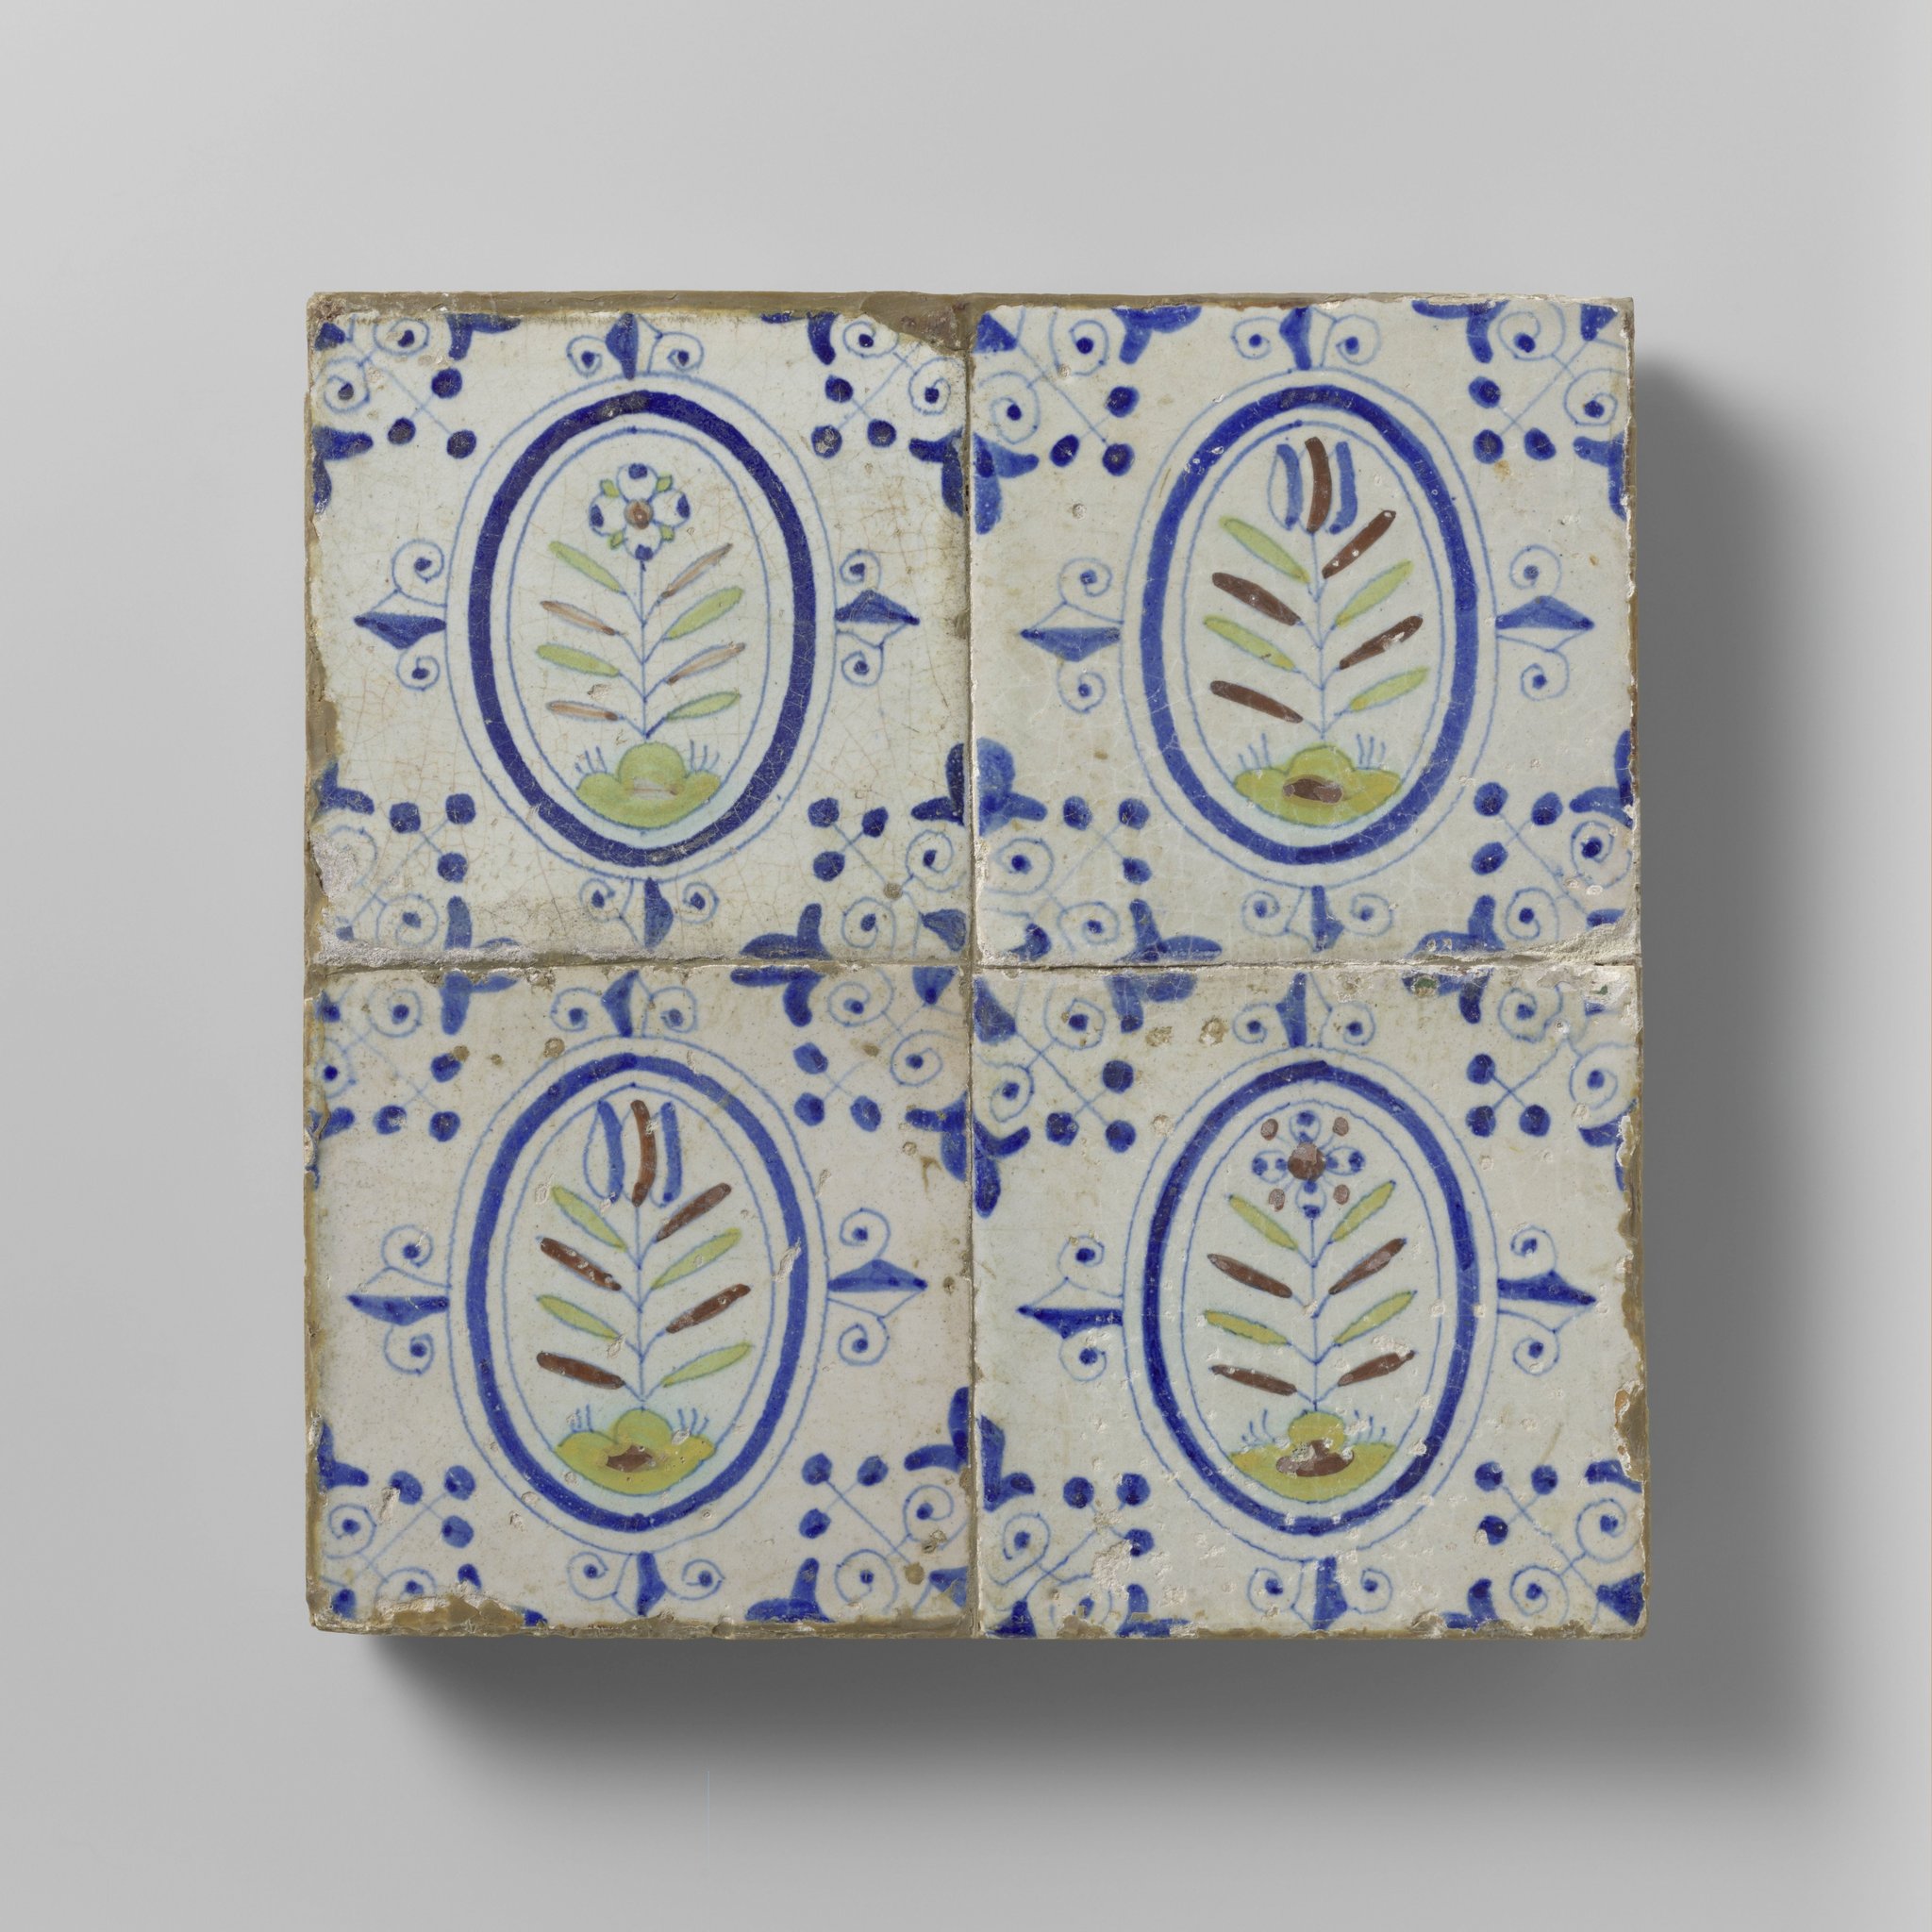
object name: tile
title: Veld van vier tegels met bloemen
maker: Anonymous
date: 1640-1660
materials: earthenware, glaze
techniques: maiolica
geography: netherlands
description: Veld van 4 tegels (2 x 2) elk met een veelkleurige (blauw, groen, geel en oranje) bloem op bol binnen een ovaal met lelie, en in de hoeken een driestip.